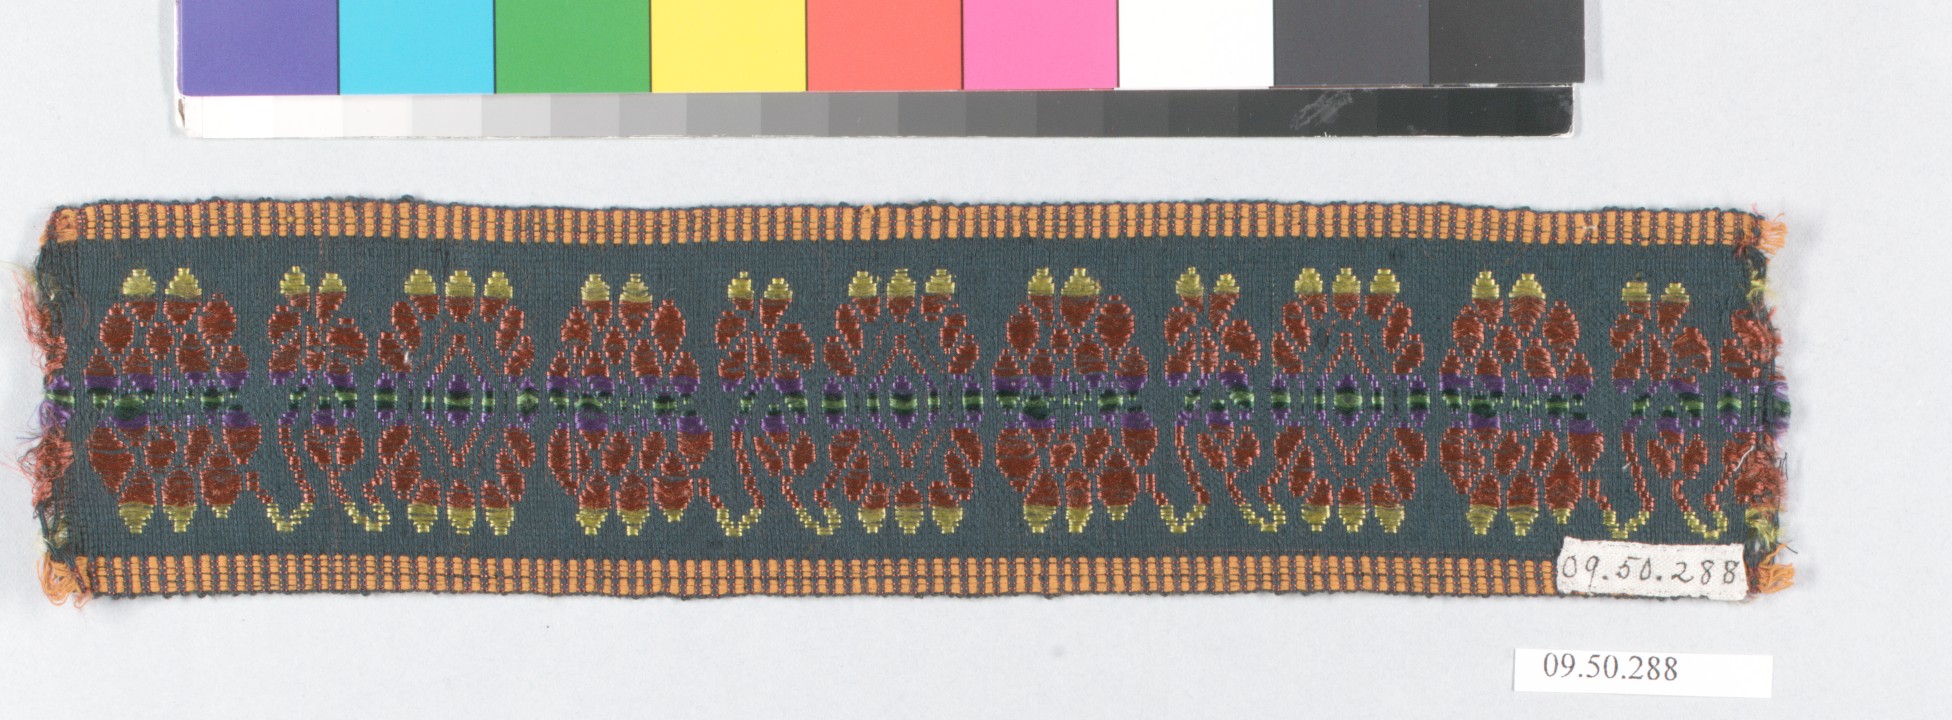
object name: ribbon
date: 1801-1900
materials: cotton, silk